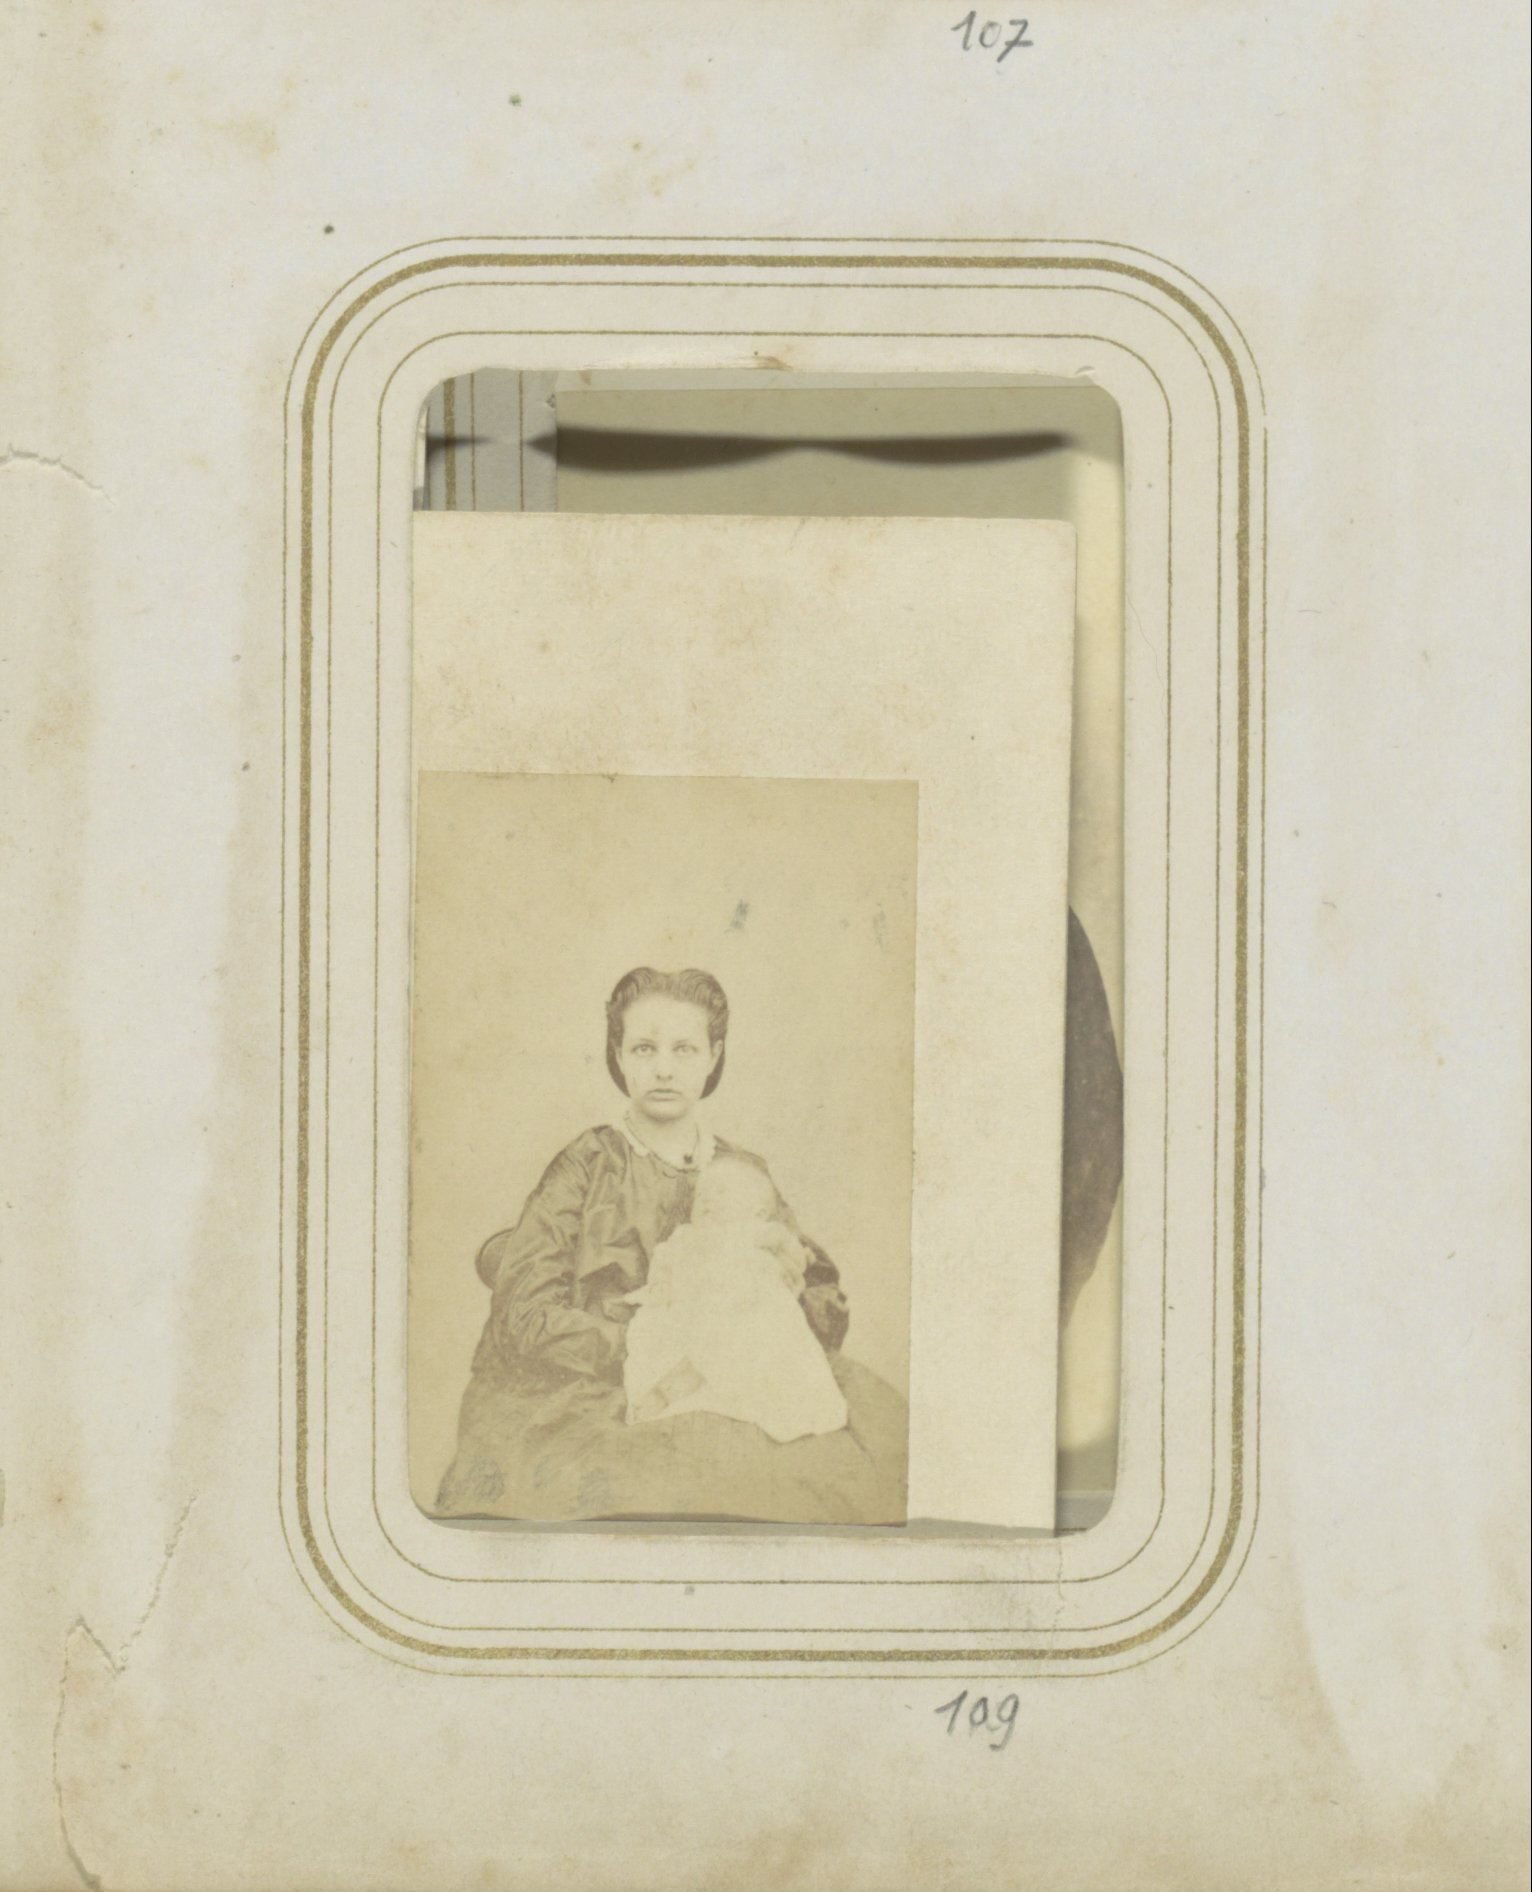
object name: carte de visite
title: Portret van een vrouw in een jurk met een baby op schoot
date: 1860-1880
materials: cardboard, photographic support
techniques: albumen print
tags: historical persons, styles of hairdress - aa - ~ women, family, relationship, descent, infant, baby ~ the ages of man, dress, gown, netherlands, dutch east indies, the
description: Onderdeel van Familiealbum van H.W.F. Ligtenberg en L.M. Swart met 149 foto's en cartes-de-visite.